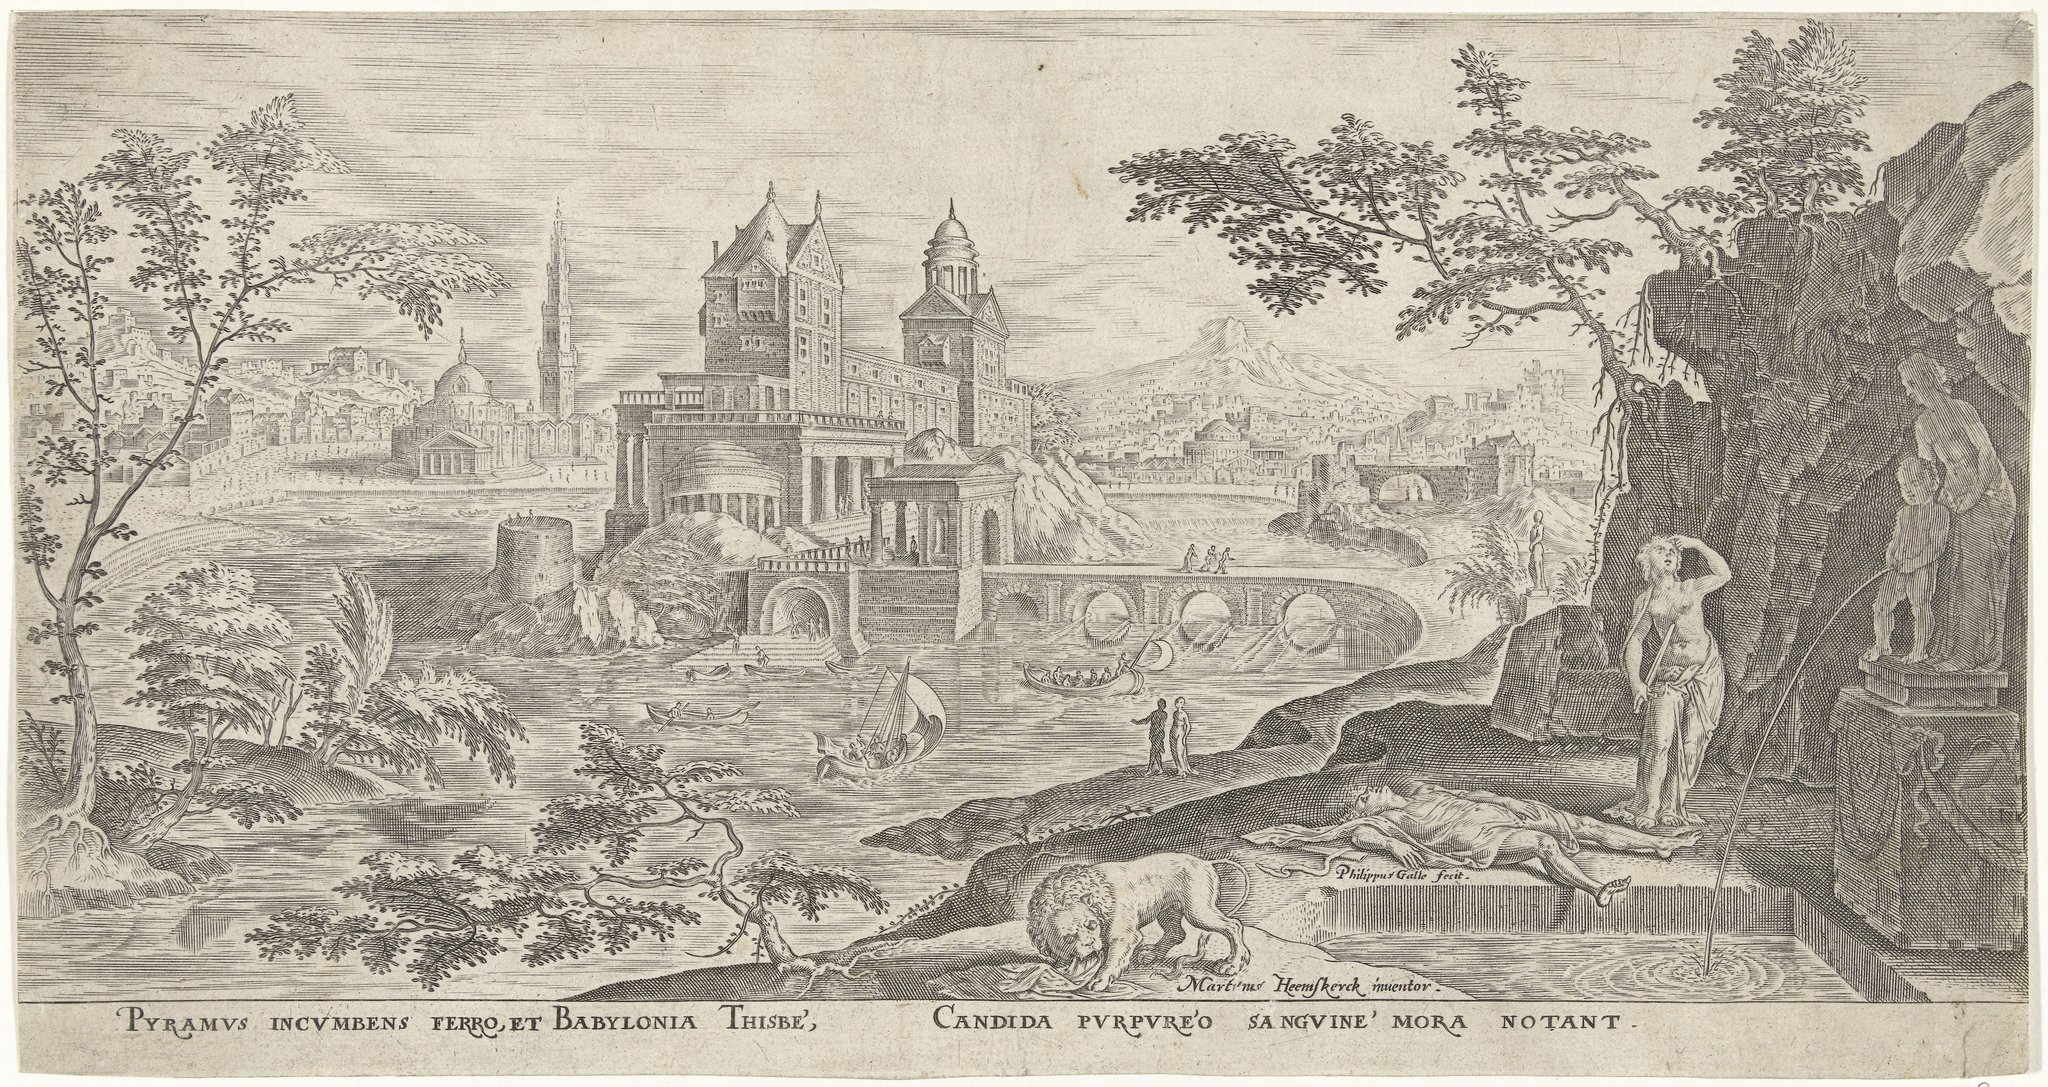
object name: print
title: Landschap met de zelfmoord van Thisbe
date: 1567-1571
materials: paper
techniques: engraving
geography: haarlem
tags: thisbe kills herself with pyramus' sword (the scene may be represented near a fountain), landscapes with waters, waterscapes, seascapes (in the temperate zone) - hh - ideal landscapes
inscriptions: collector's mark: Lugt 2228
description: In de achtergrond een fantasielandschap met een kasteel. In de voorgrond Thisbe, die bij het zien van Piramus' lijk zichzelf met een zwaard doorboort. Naast het lijk van Piramus de leeuw die de mantel van Thisbe verscheurd. De prent heeft een Latijns onderschrift.